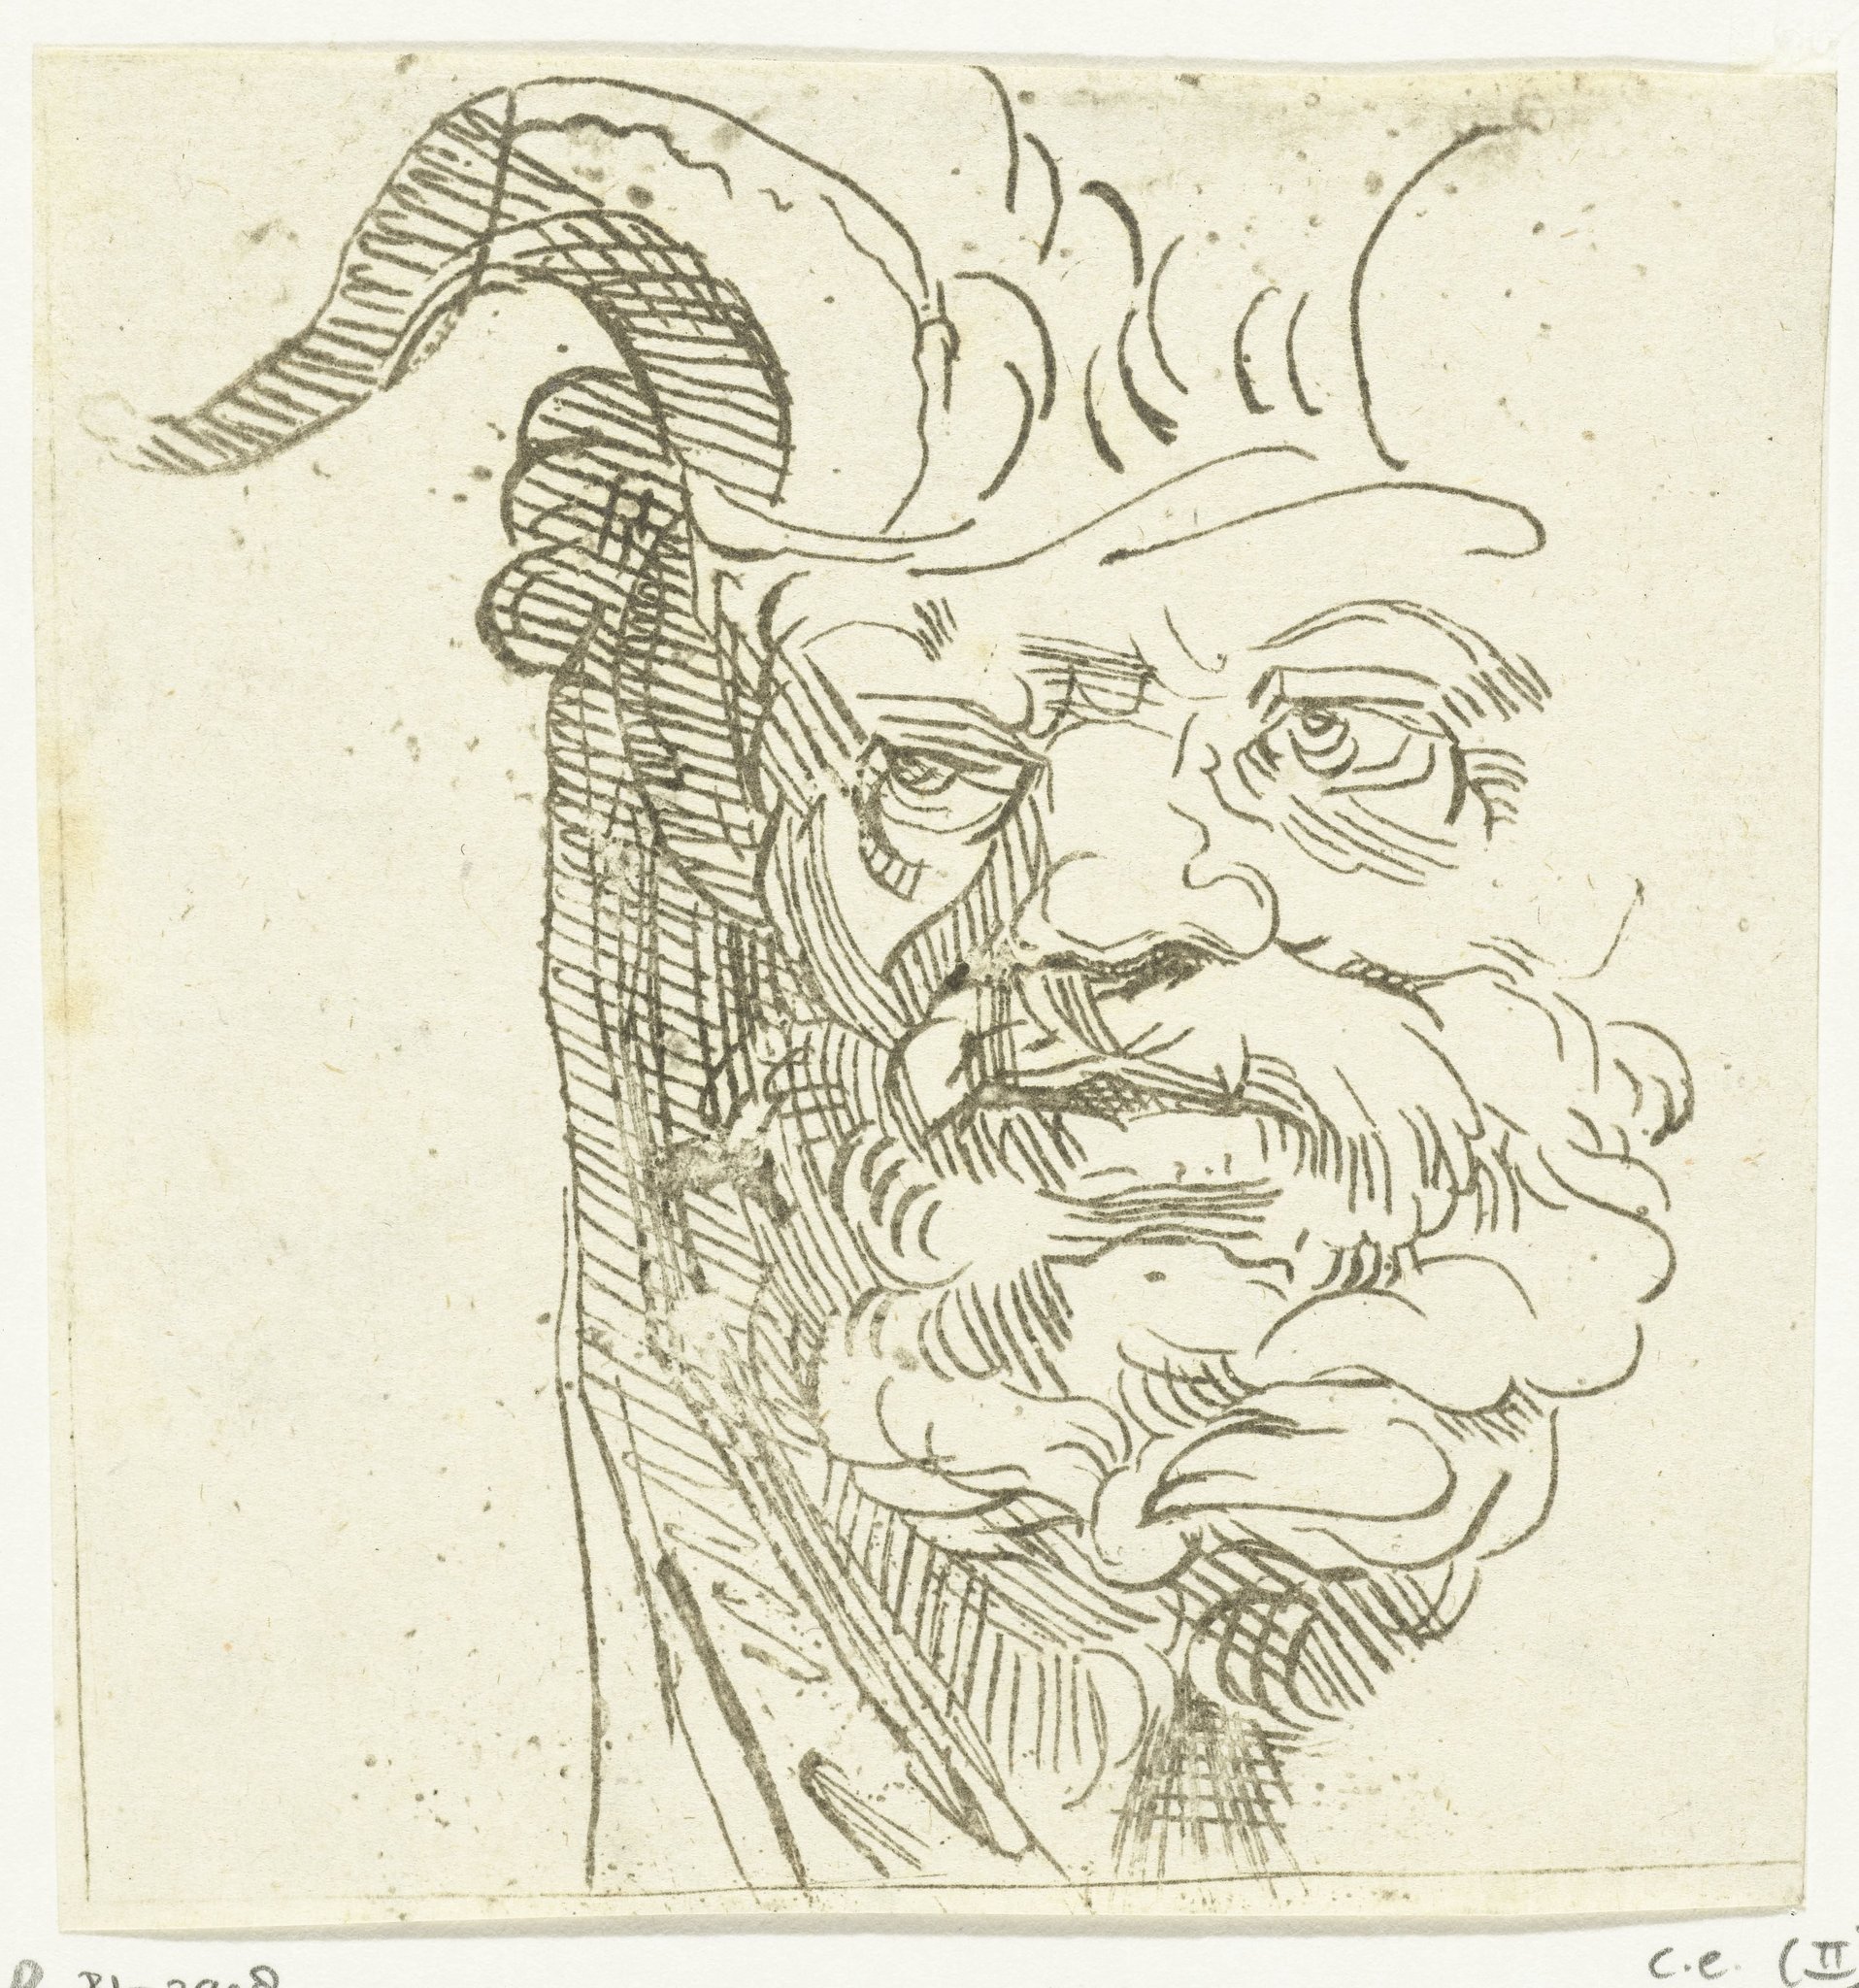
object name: print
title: Kop van een sater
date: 1778-1838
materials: paper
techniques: printmaking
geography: netherlands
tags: satyr(s) (in general)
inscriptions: collector's mark: Lugt 2228